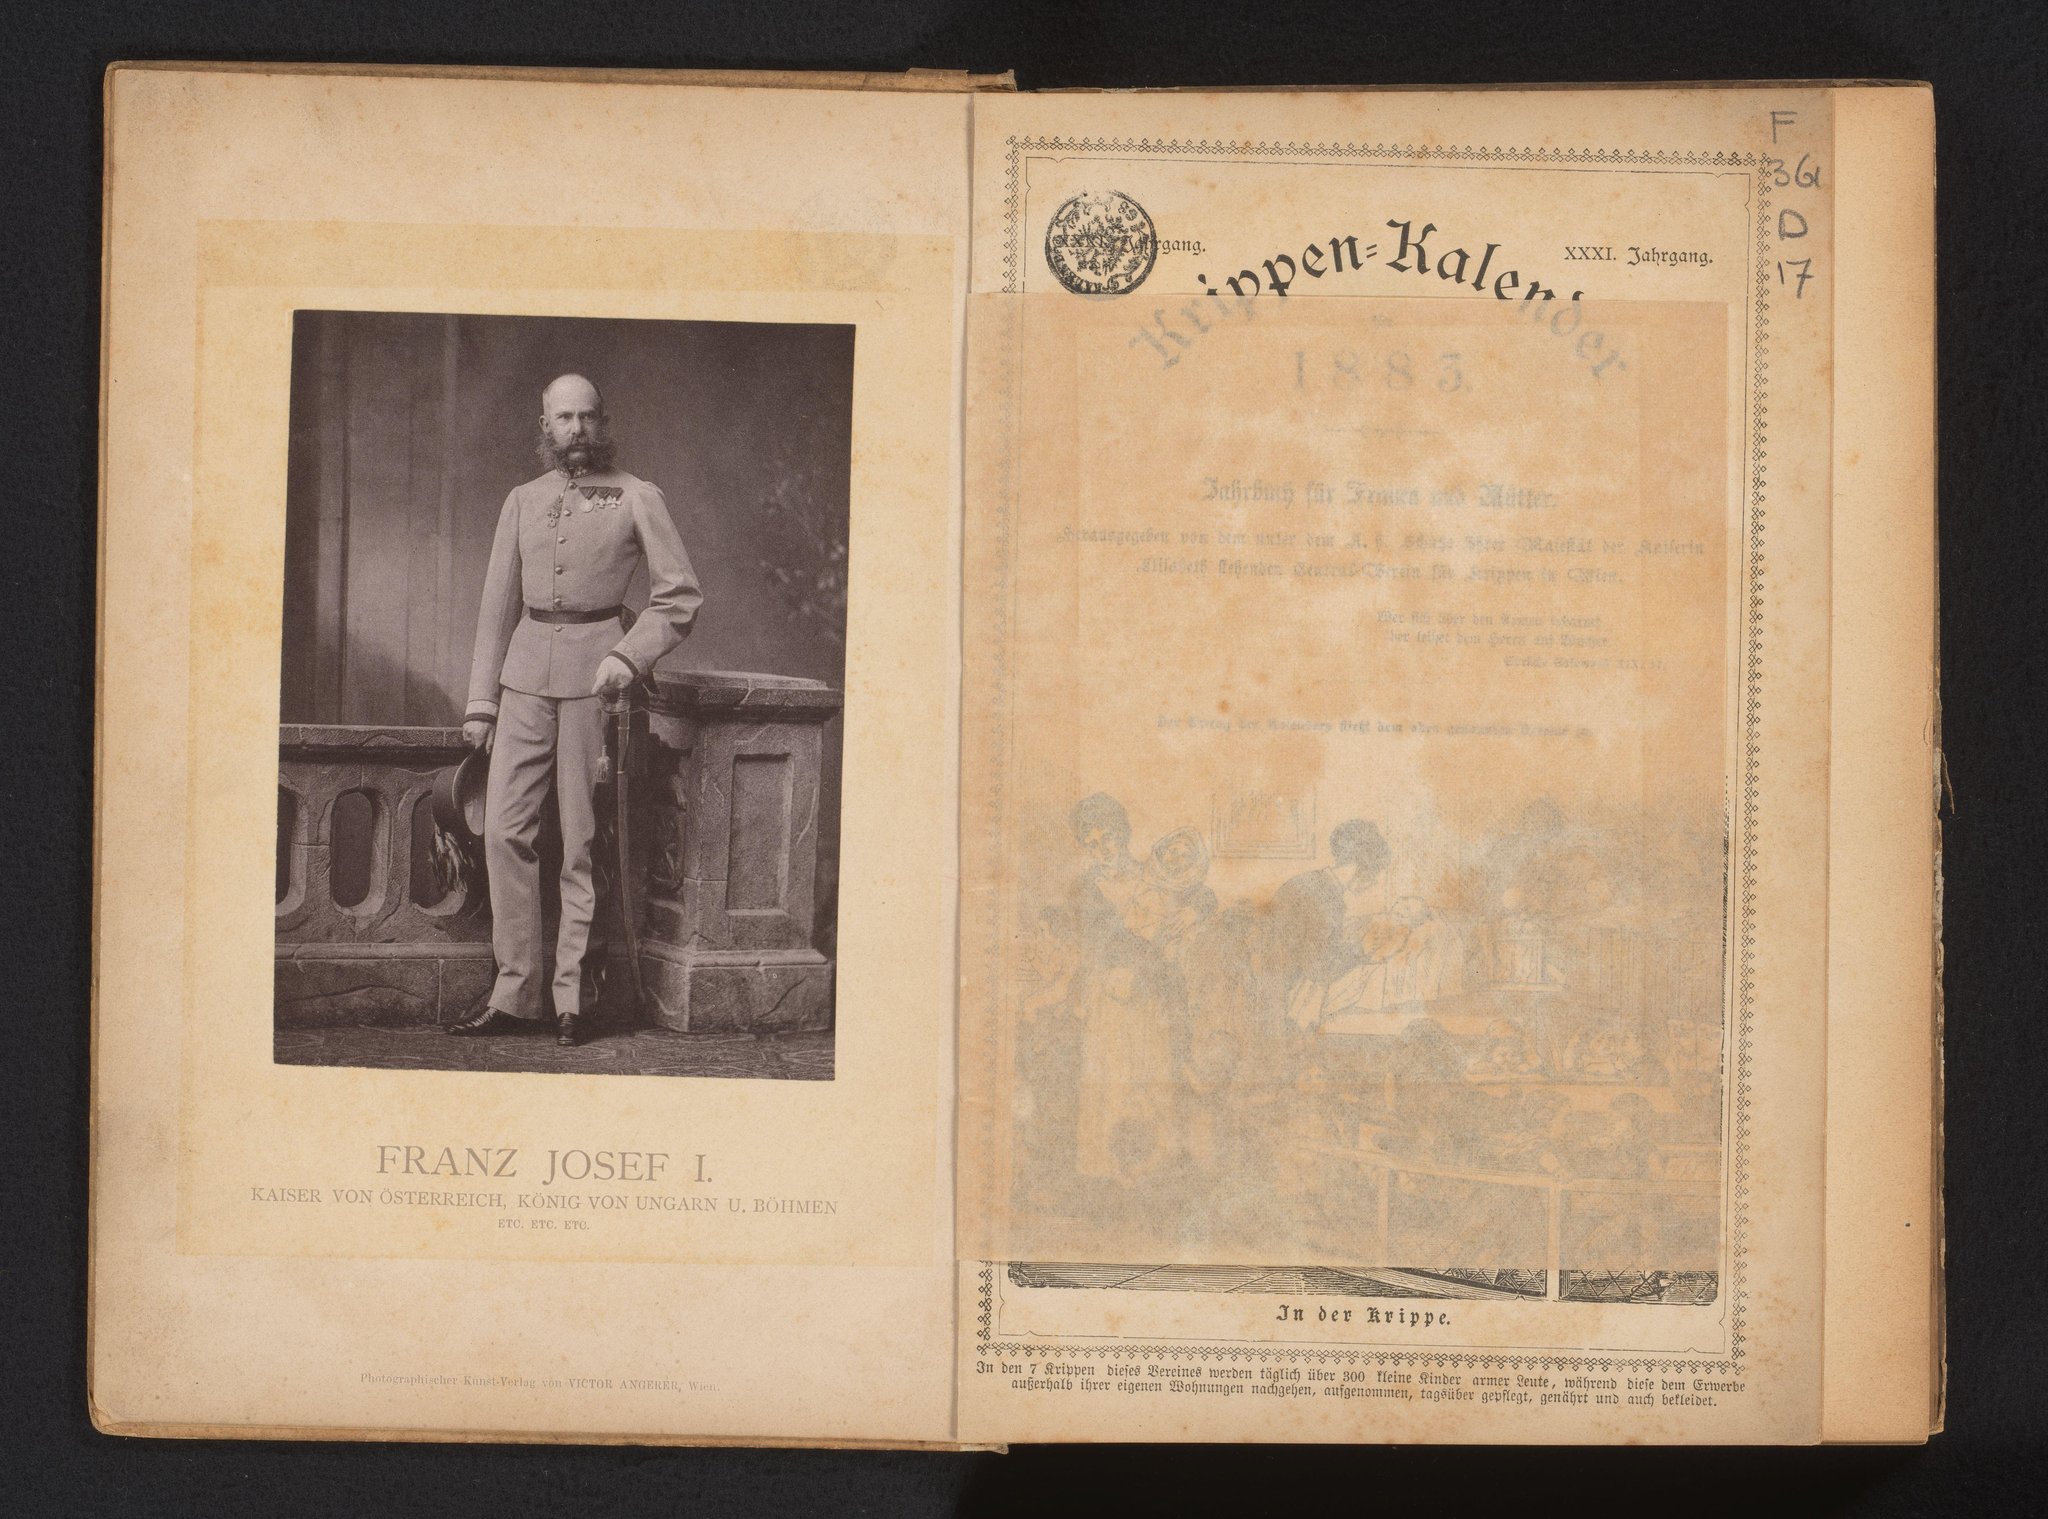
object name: photomechanical print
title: Portret van Frans Jozef I, keizer van Oostenrijk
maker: victor angerer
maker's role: publisher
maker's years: 1839-1924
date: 1878-1883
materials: paper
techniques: photograph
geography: vienna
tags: historical persons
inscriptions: inscription: ‘KAISER VON ÖSTERREICH, KÖNIG VON UNGARN U. BÖHMEN/ etc. etc. etc.’